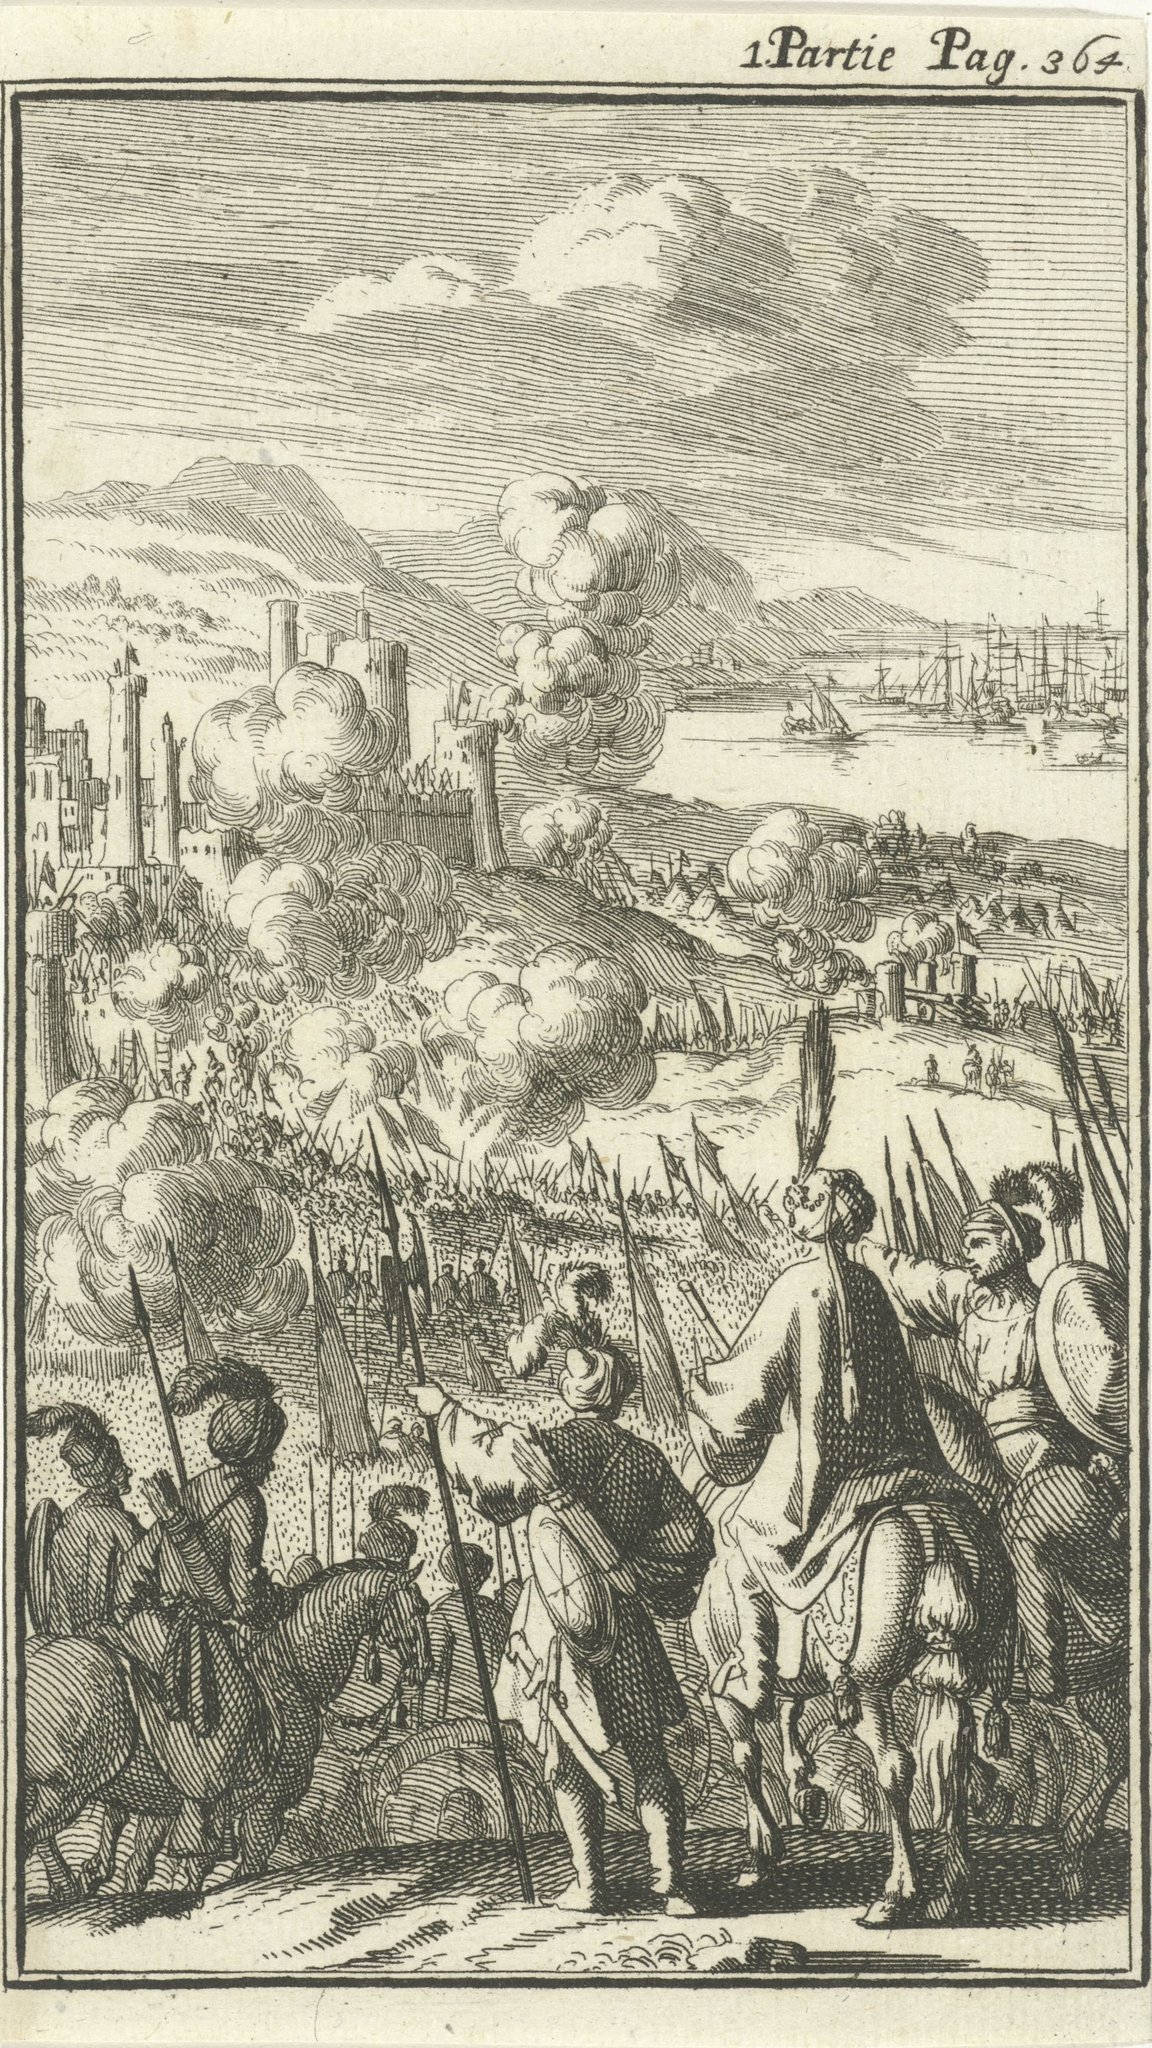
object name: print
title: Rhodos door de Turken belegerd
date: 1689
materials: paper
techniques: etching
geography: paris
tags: (military) attack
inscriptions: collector's mark: Lugt 2228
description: Illustratie uit: Thevenot, Jean de. Voyages Tant en Europe qu'en Asie et en Afrique, 4 delen. Parijs: Charles Angot, 1689, dl. I.